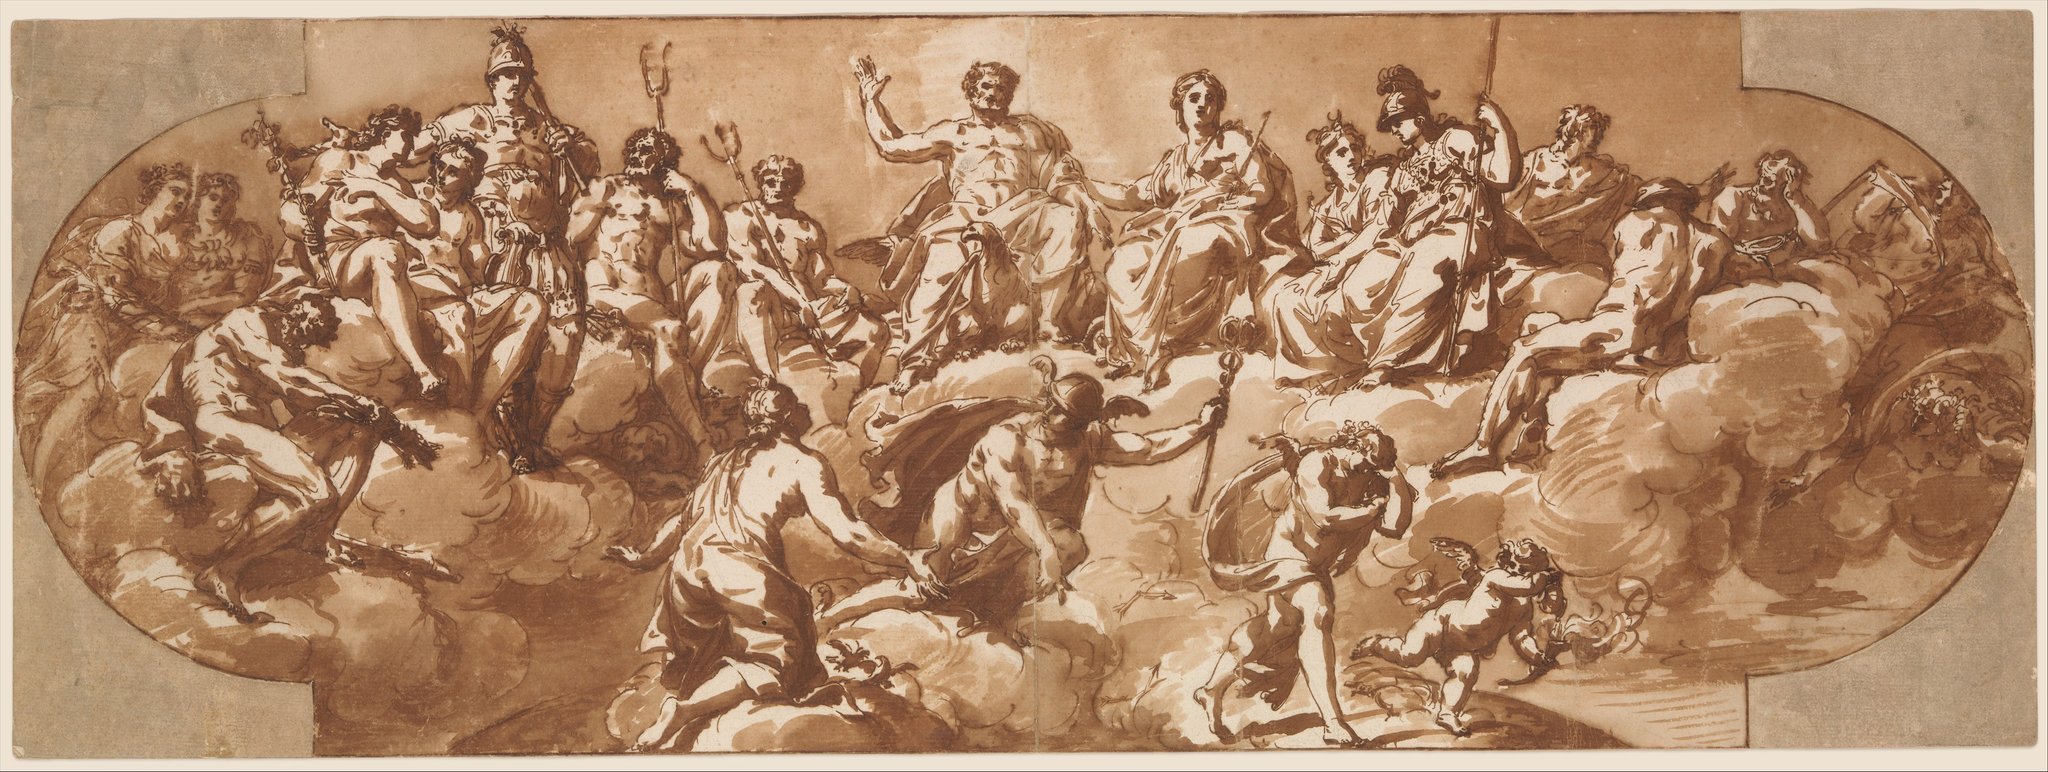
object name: drawing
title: Council of the Gods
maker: giacomo zoboli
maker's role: artist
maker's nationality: italian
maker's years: 1681-1767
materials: chalk, ink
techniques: brush, pen, wash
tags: men,women,gods